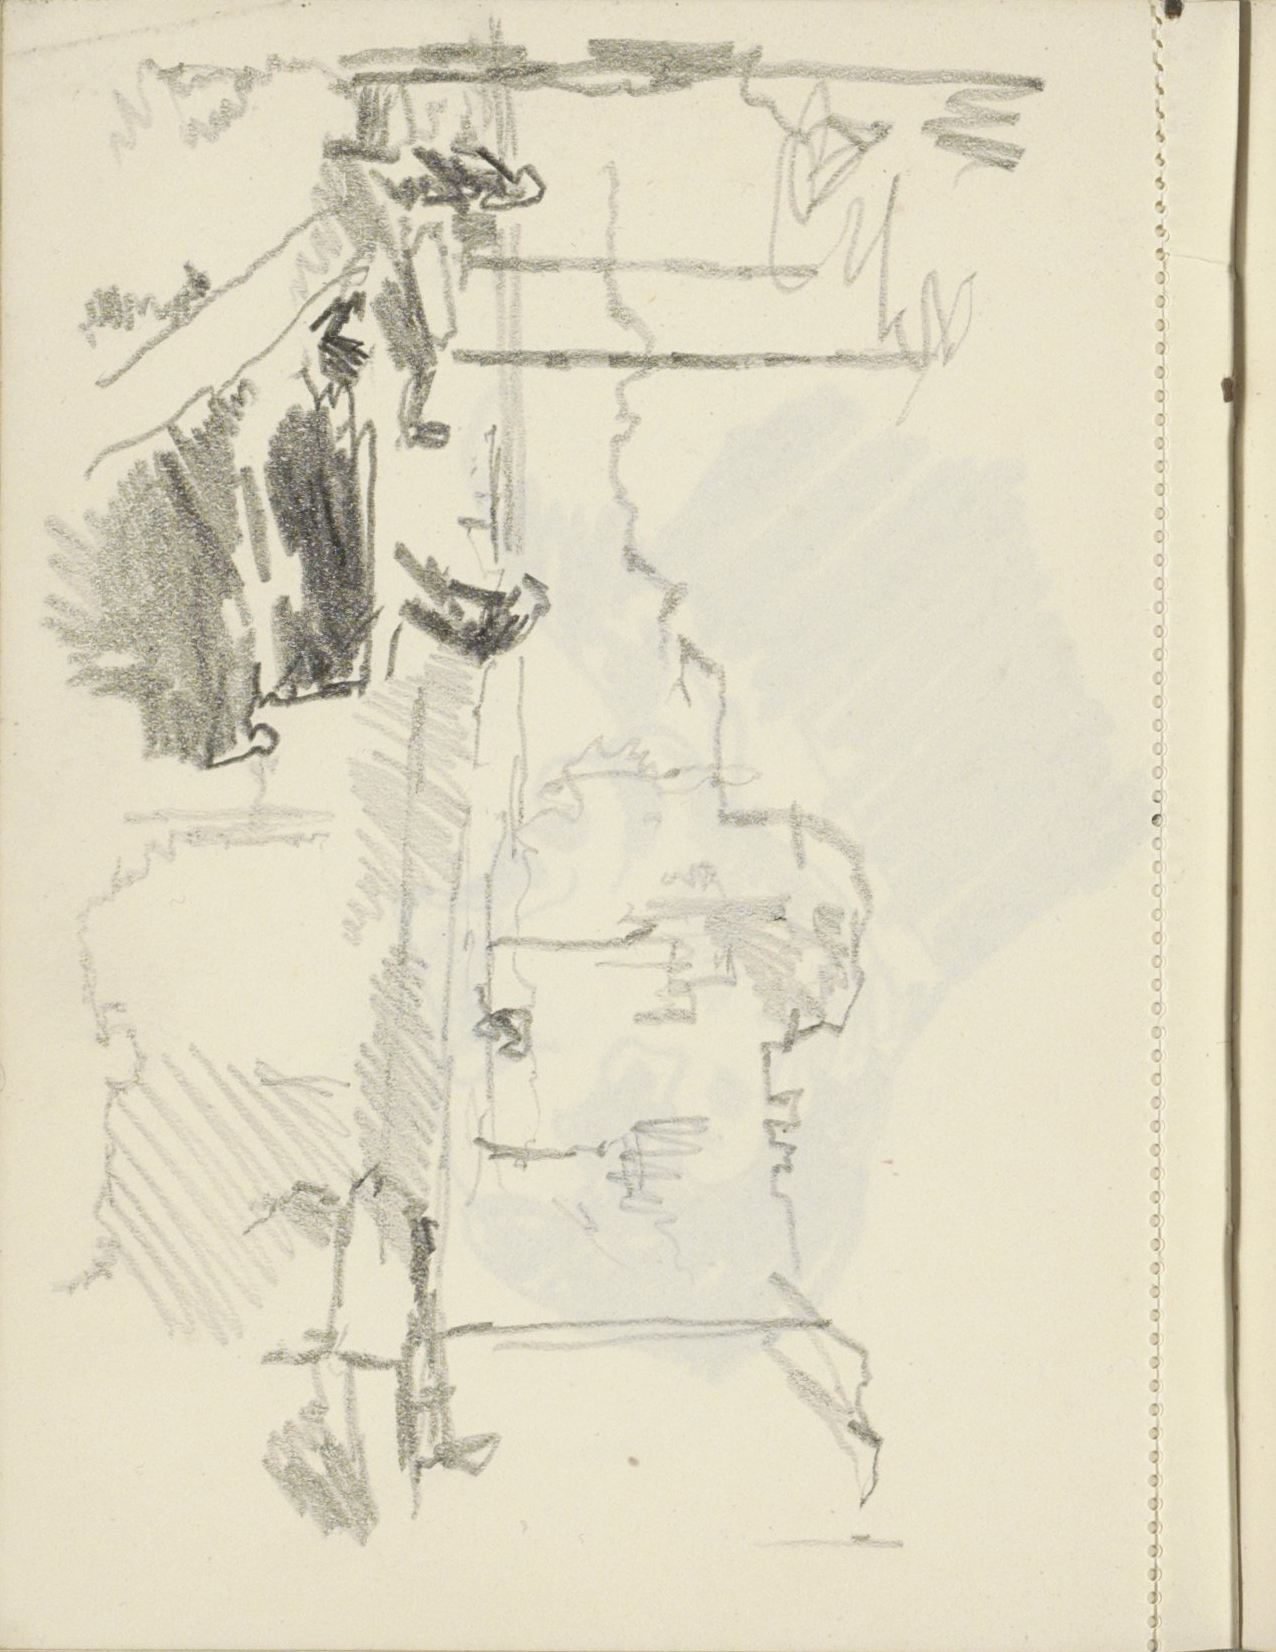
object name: sketchbook leaf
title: Aangemeerde boot aan een waterkant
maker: cornelis vreedenburgh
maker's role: draughtsman, print maker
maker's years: 1880-1946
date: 1890-1946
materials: paper, pencil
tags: sailing-ship, sailing-boat, canals, waters (in city)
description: Op en naast de boot staat een figuur. Blad 61 verso uit een schetsboek met 71 bladen.